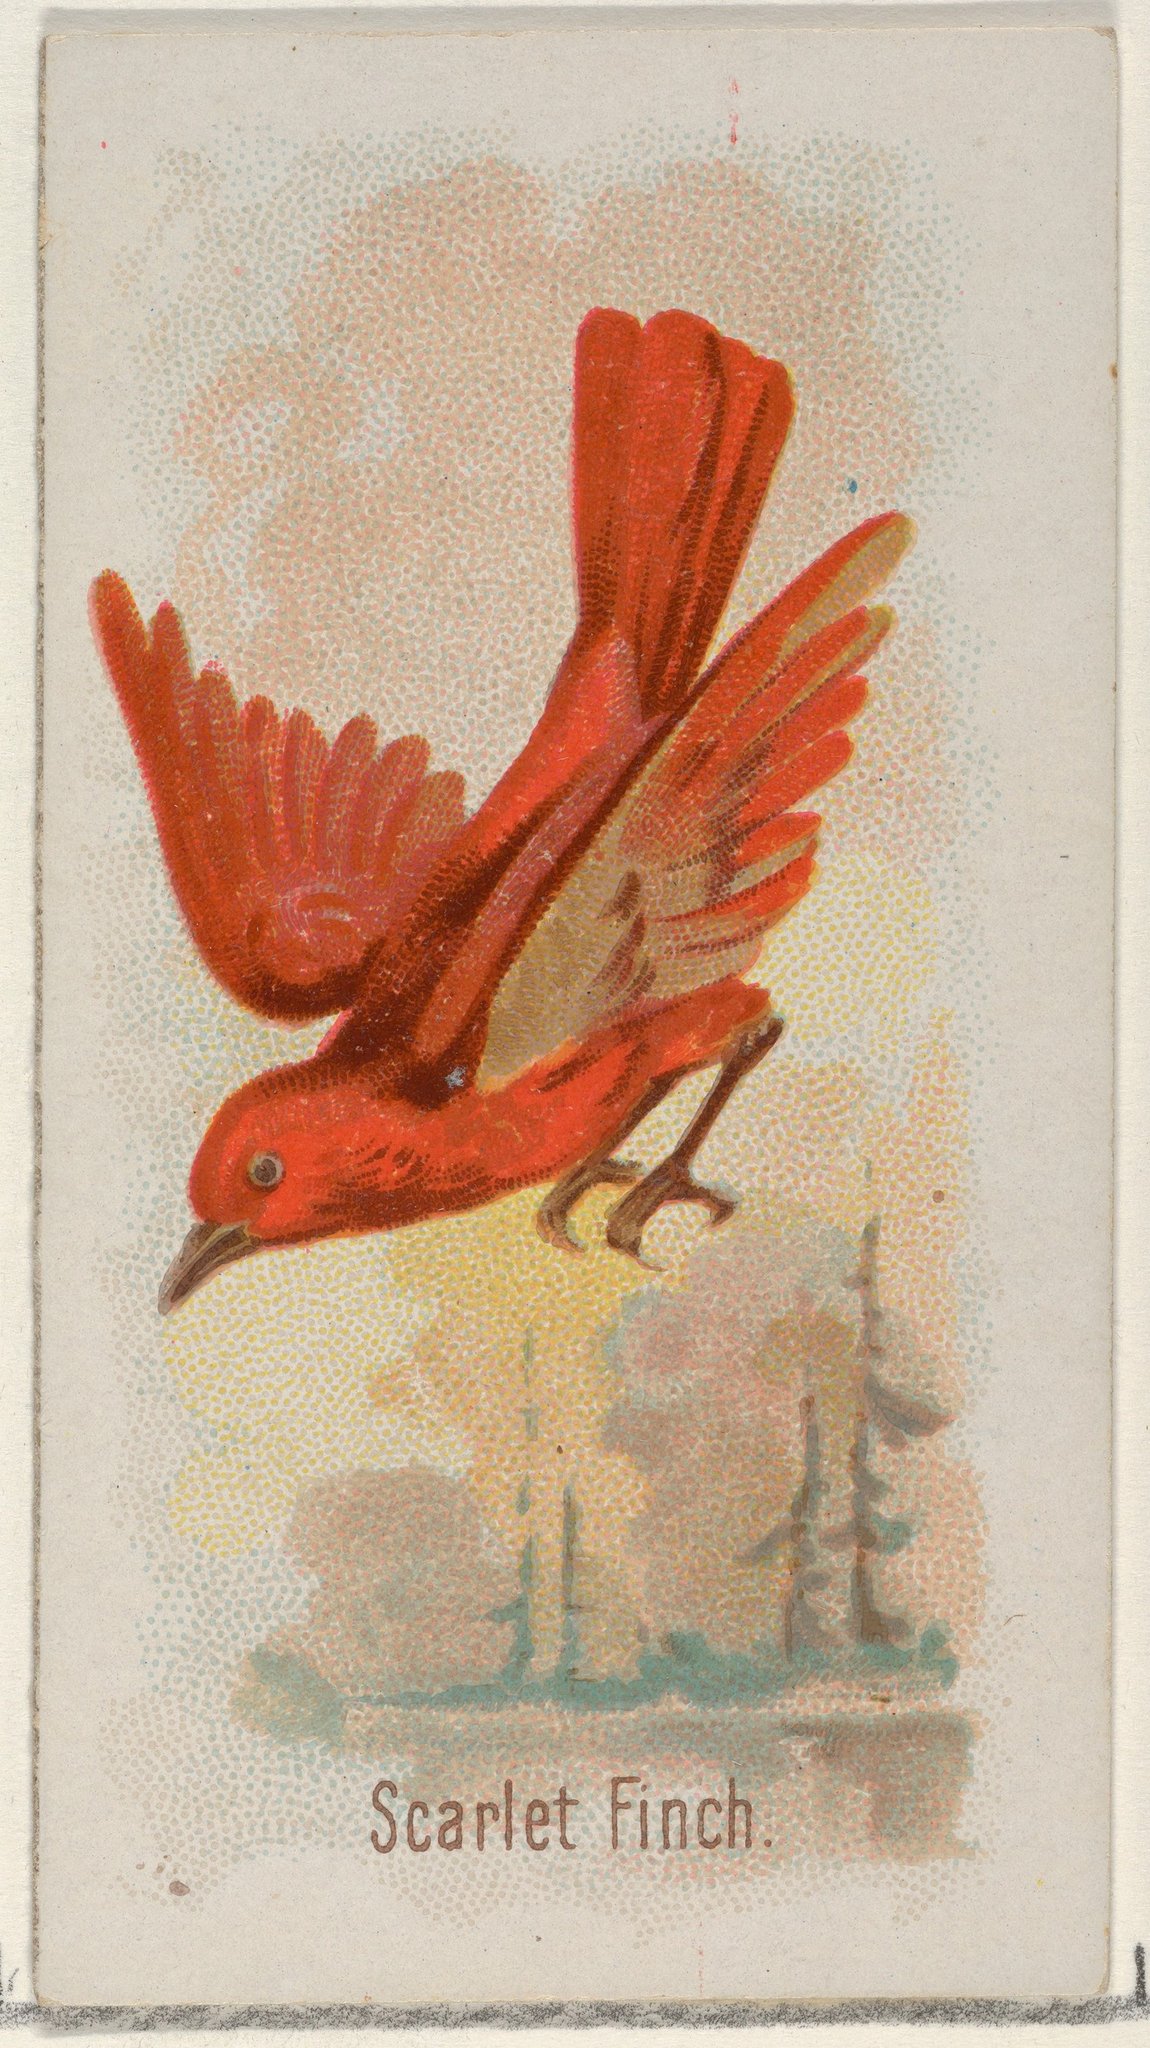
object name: print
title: Scarlet Finch, from the Song Birds of the World series (N23) for Allen & Ginter Cigarettes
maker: allen & ginter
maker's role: publisher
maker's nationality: american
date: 1890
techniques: color lithograph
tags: birds